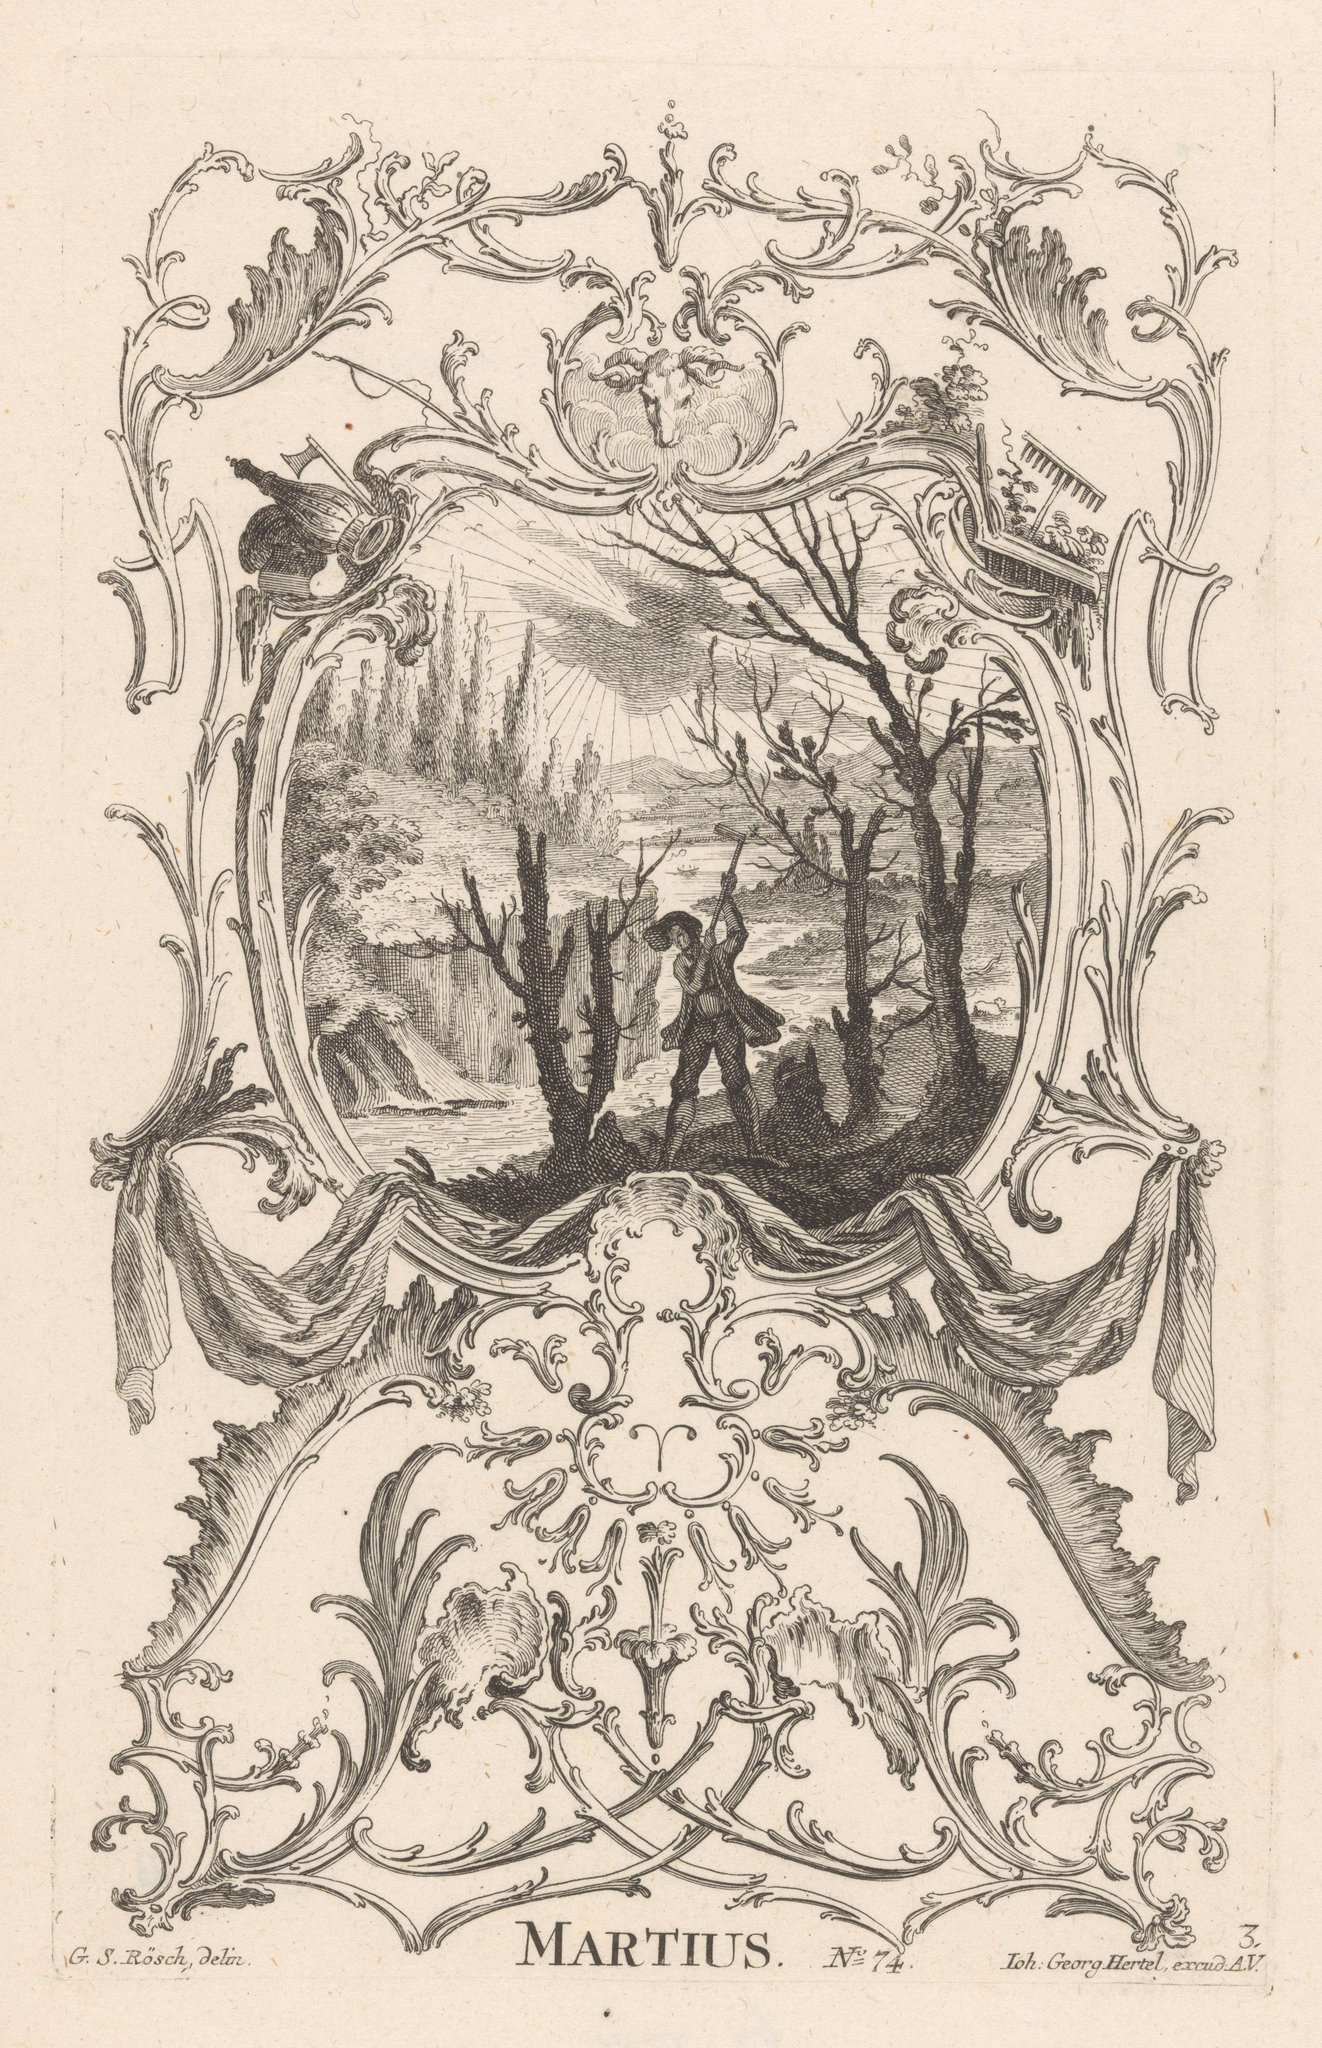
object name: ornament print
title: Maart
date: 1705-1766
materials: paper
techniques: etching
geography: augsburg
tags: woodcutting, woodcutter ~ forestry, march and its 'labours'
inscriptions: collector's mark: Lugt 2760, collector's mark: Lugt 2228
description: In een rocaille cartouche een houthakker in het bos. Rondom de voorstelling rocaille ornamenten, een ram en het bijbehorende teken van de dierenriem. Uitgeversnummer 74.